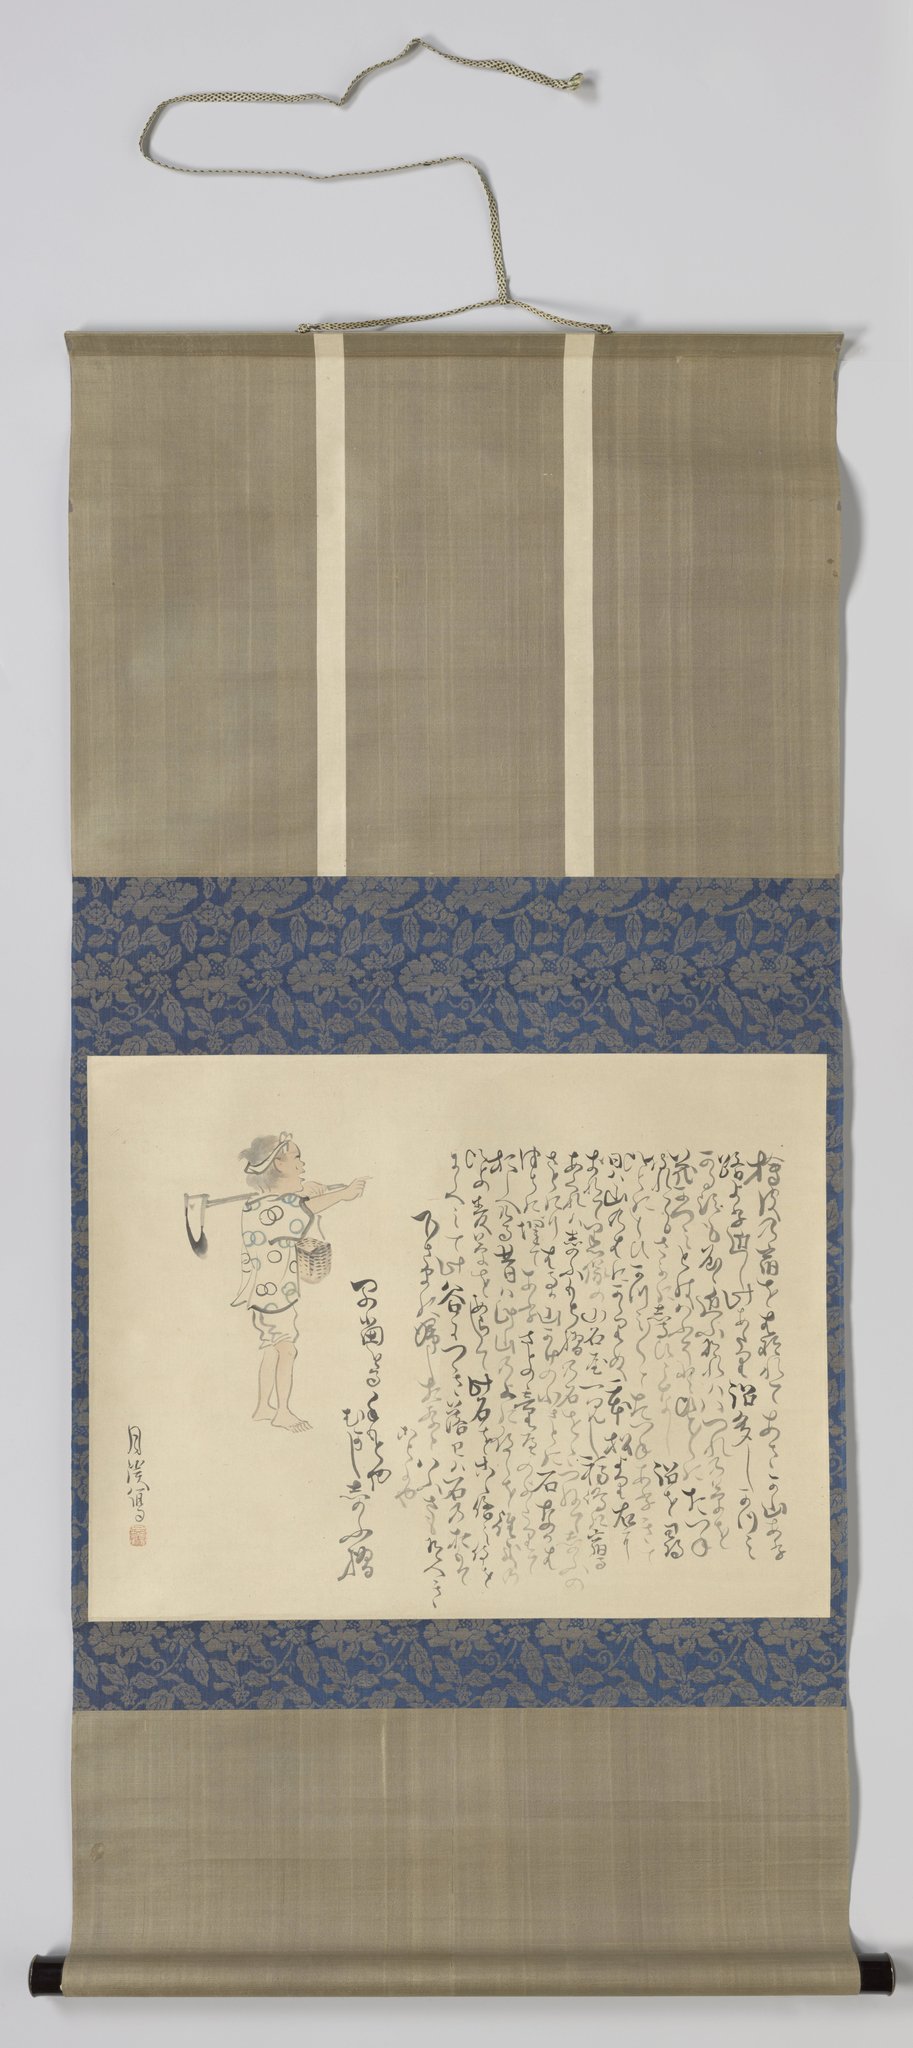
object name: hanging scroll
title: Boy with and rice seedlings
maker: matsumura goshun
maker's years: 1752-1811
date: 1777-1800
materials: lacquer, paper, silk, textile, wood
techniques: calligraphy, damask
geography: japan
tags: agricultural implements: hoe, transplanting, setting out plants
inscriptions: signature: ‘月渓写’, inscription: ‘月渓翁早苗句画賛’, seal: ‘呉春’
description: A boy with a hoe over his shoulder is on his way to the rice paddies. The elegant lines delineating the boy dovetail with the rhythmic undulating calligraphy telling the story of the rice seedlings in the boy’s basket, which will be planted in the fields.